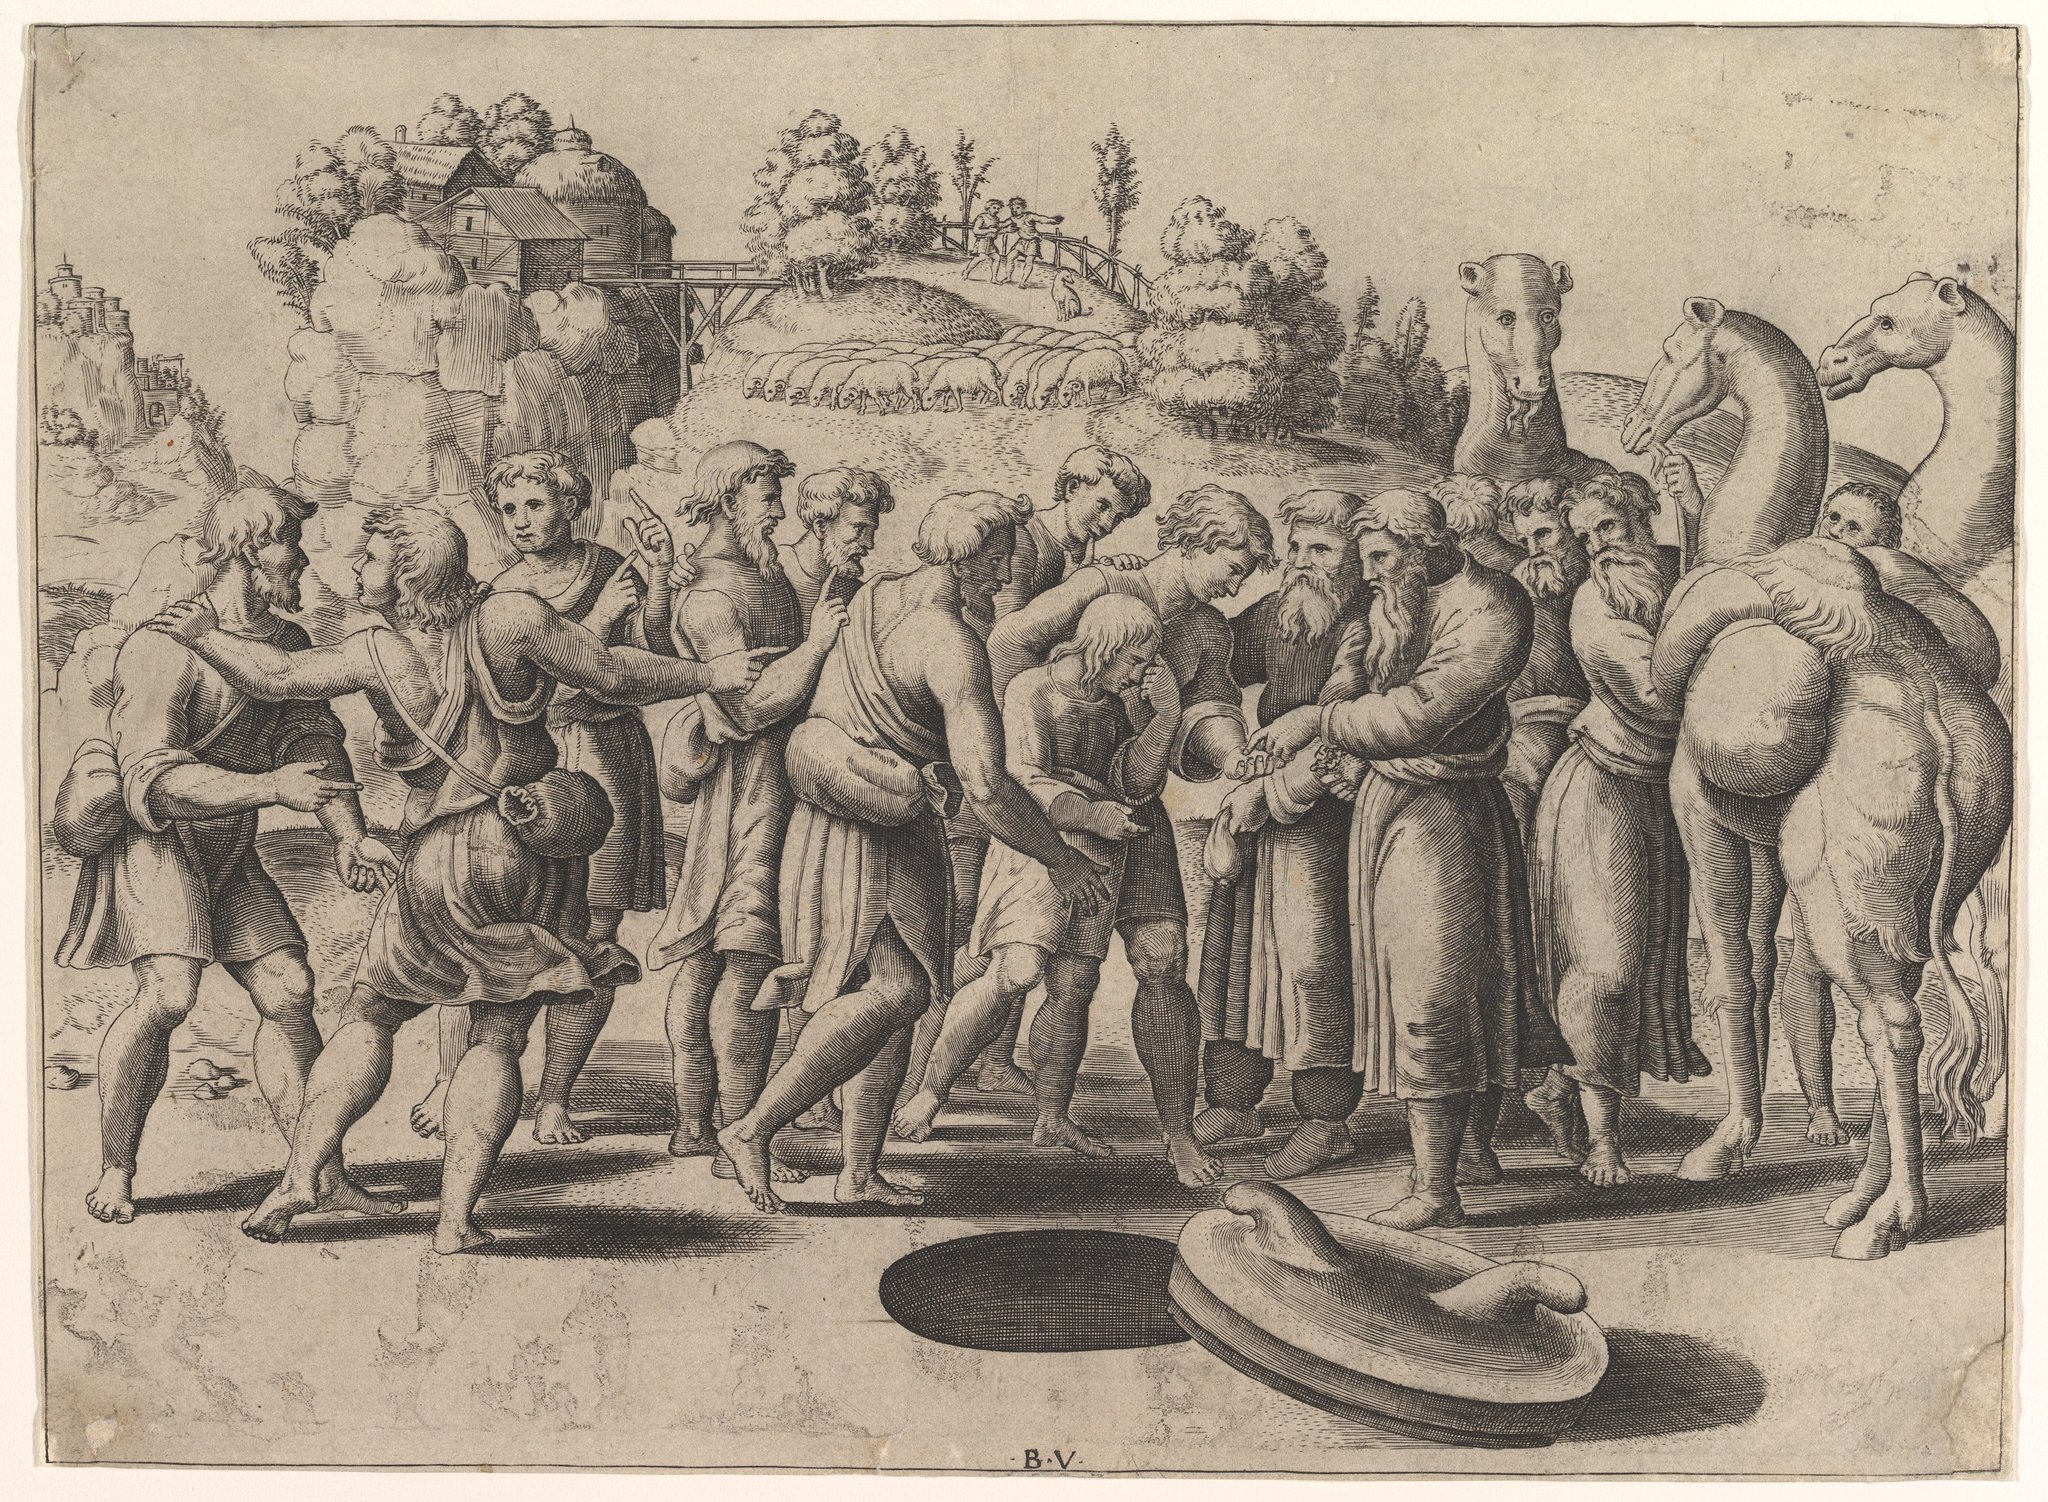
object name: print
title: Joseph in the centre being sold by his brothers standing above a well, camels at the right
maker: master of the die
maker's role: artist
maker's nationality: italian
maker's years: 1525-1560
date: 1533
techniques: engraving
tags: wells,men,camels